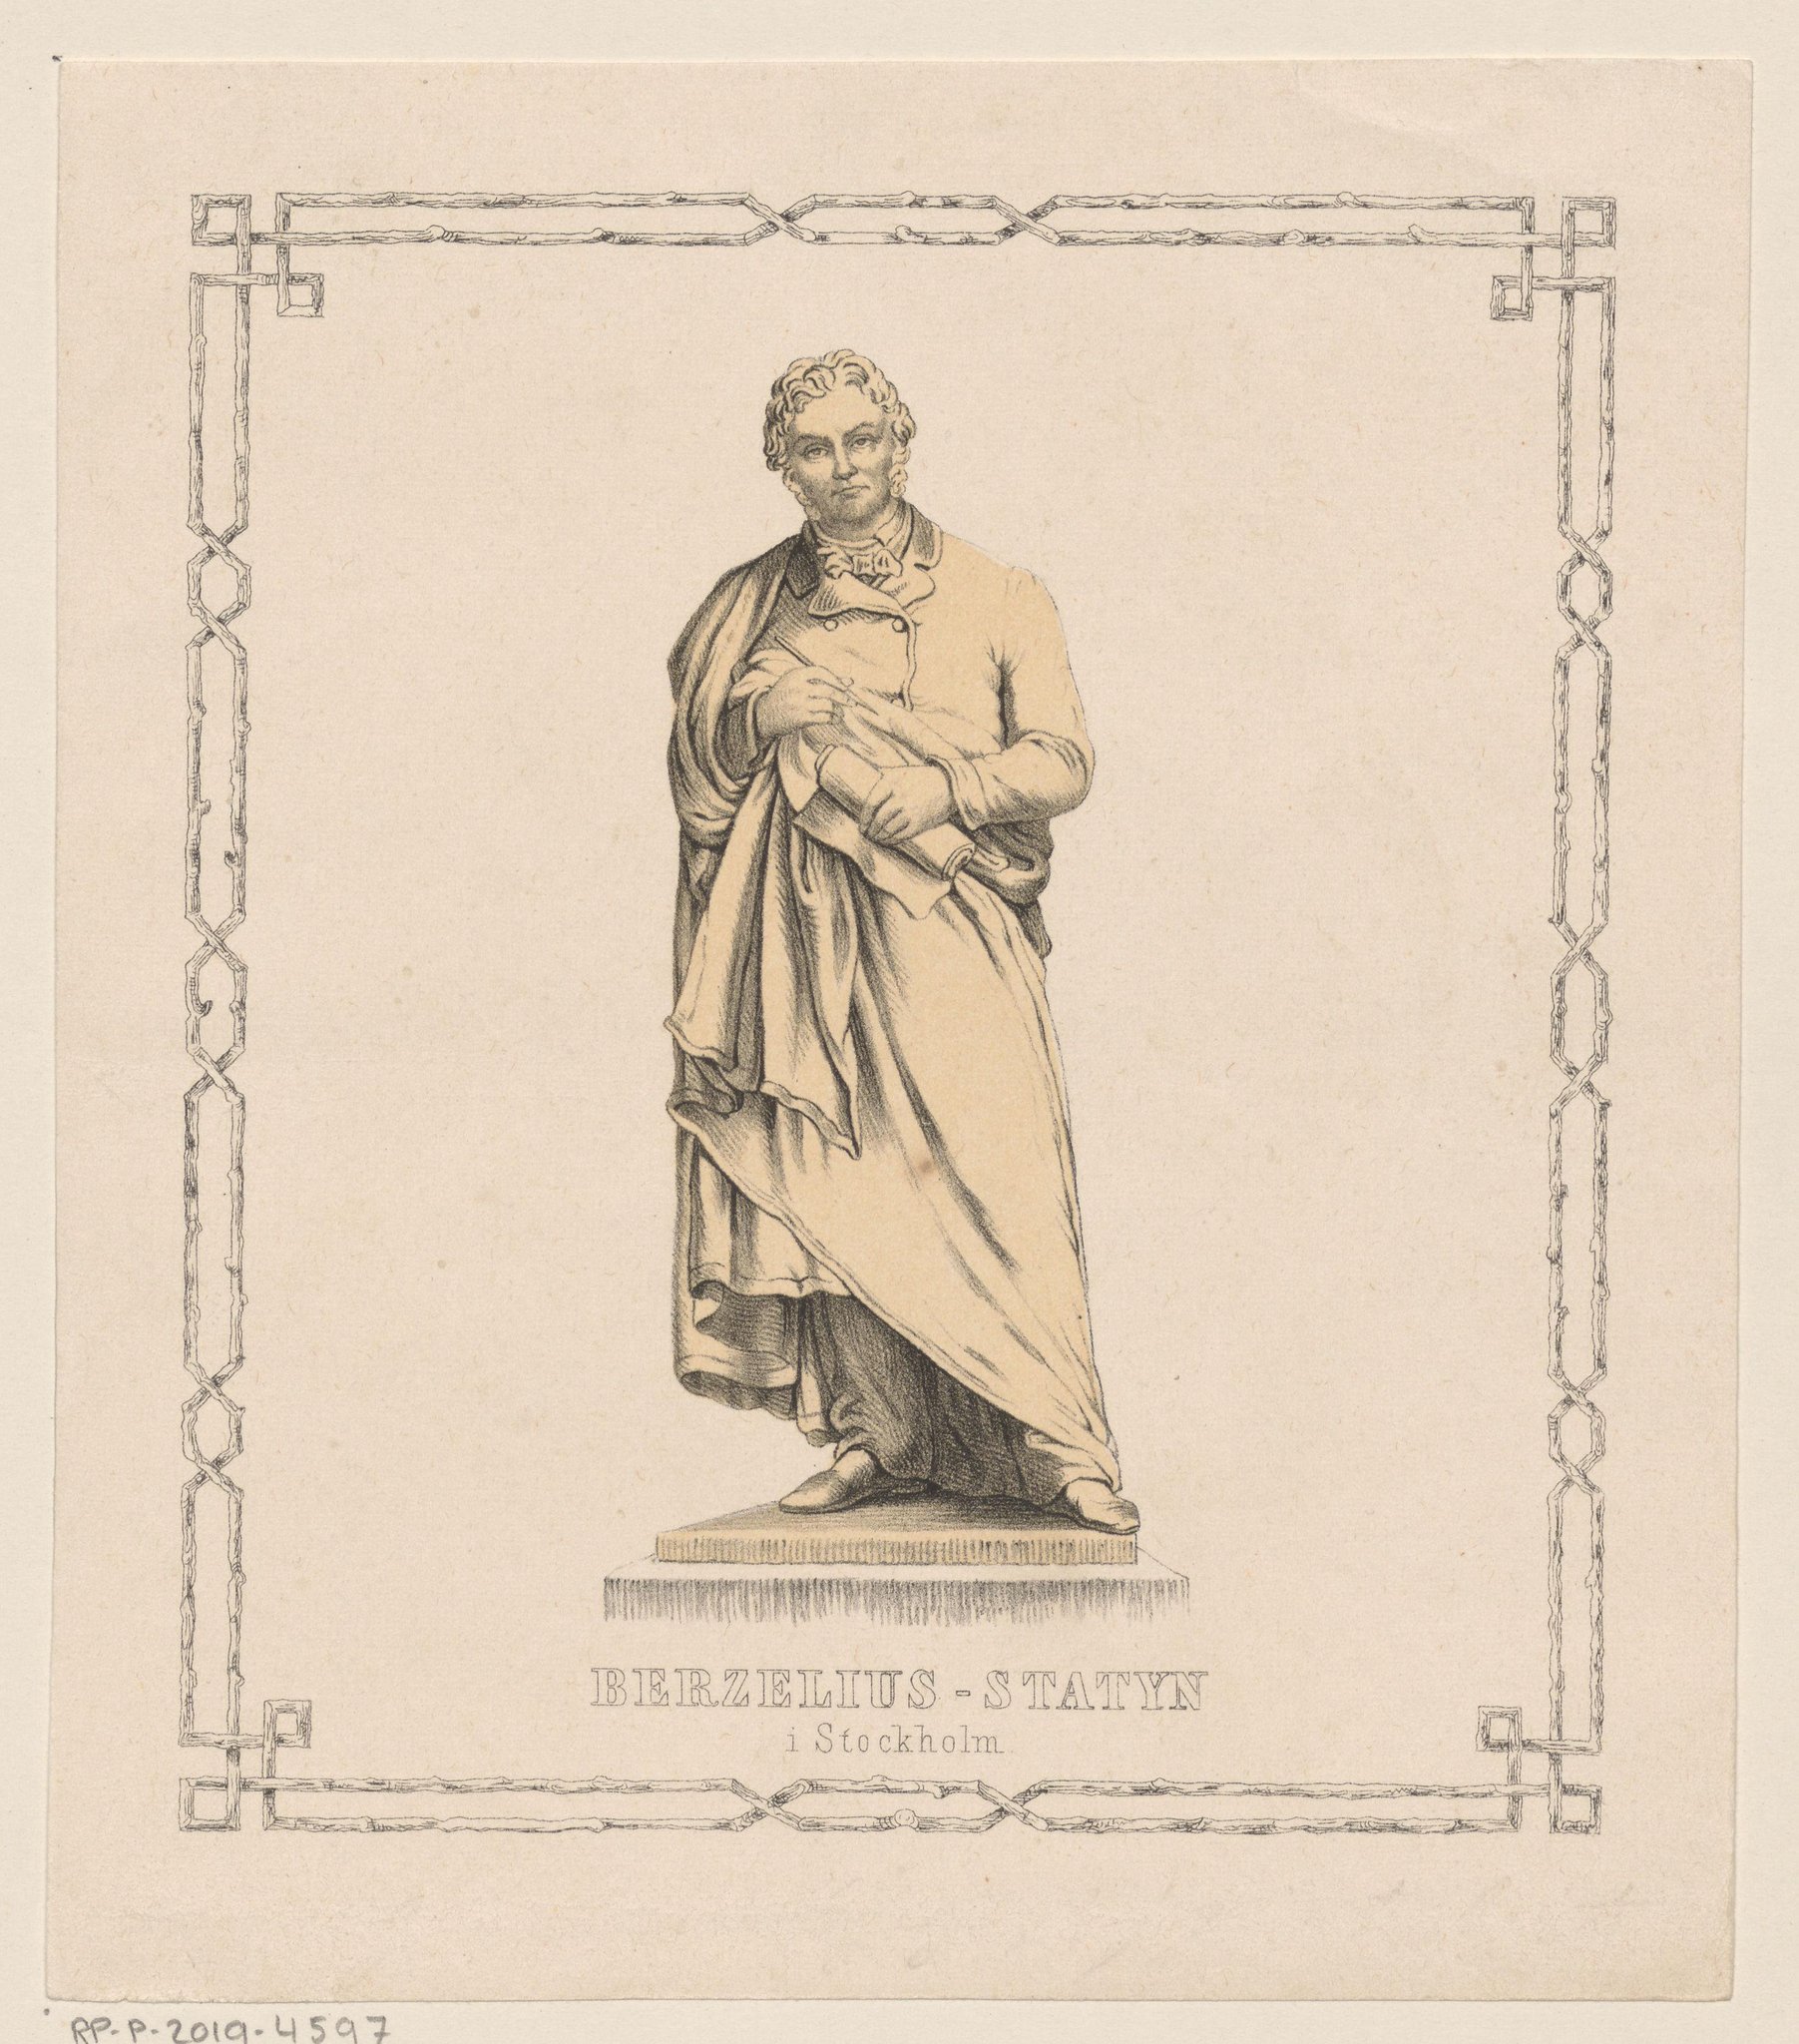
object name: print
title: Standbeeld van Jöns Jacob Berzelius te Stockholm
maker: Anonymous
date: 1858-1899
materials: paper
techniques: tone lithography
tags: historical persons, monument, statue